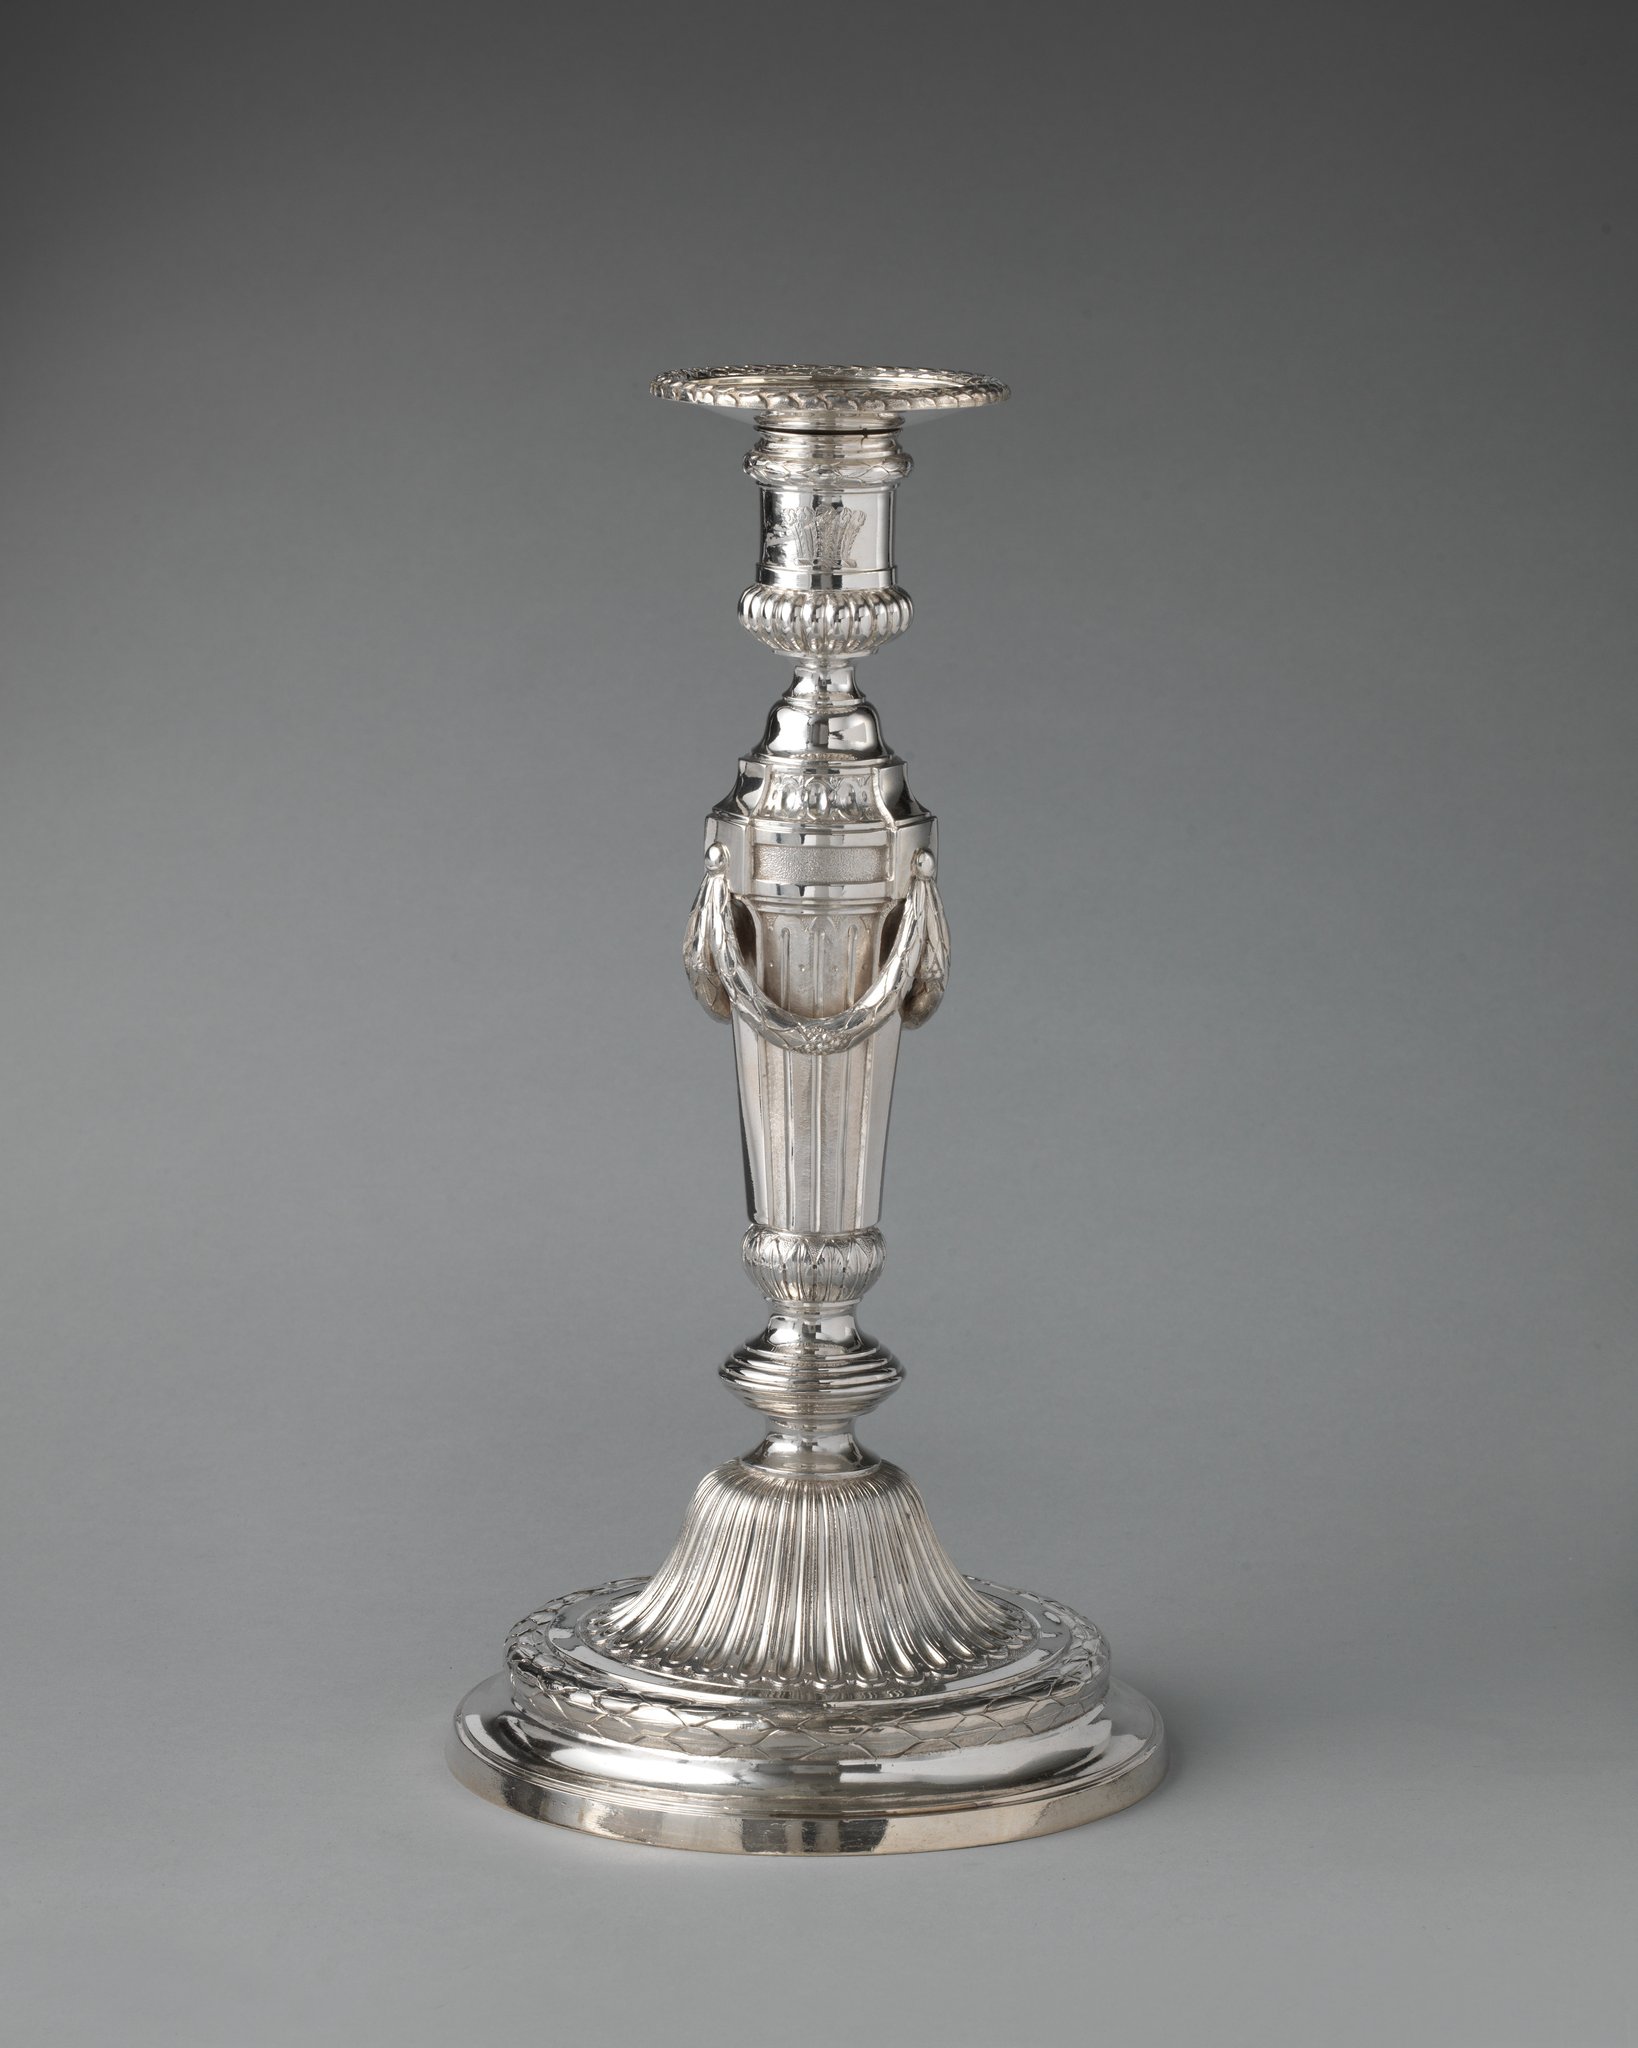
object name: candlestick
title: Candlestick (one of a set of eight)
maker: andrew fogelberg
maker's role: maker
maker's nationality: british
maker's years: 1750-1815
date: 1774-1775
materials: silver